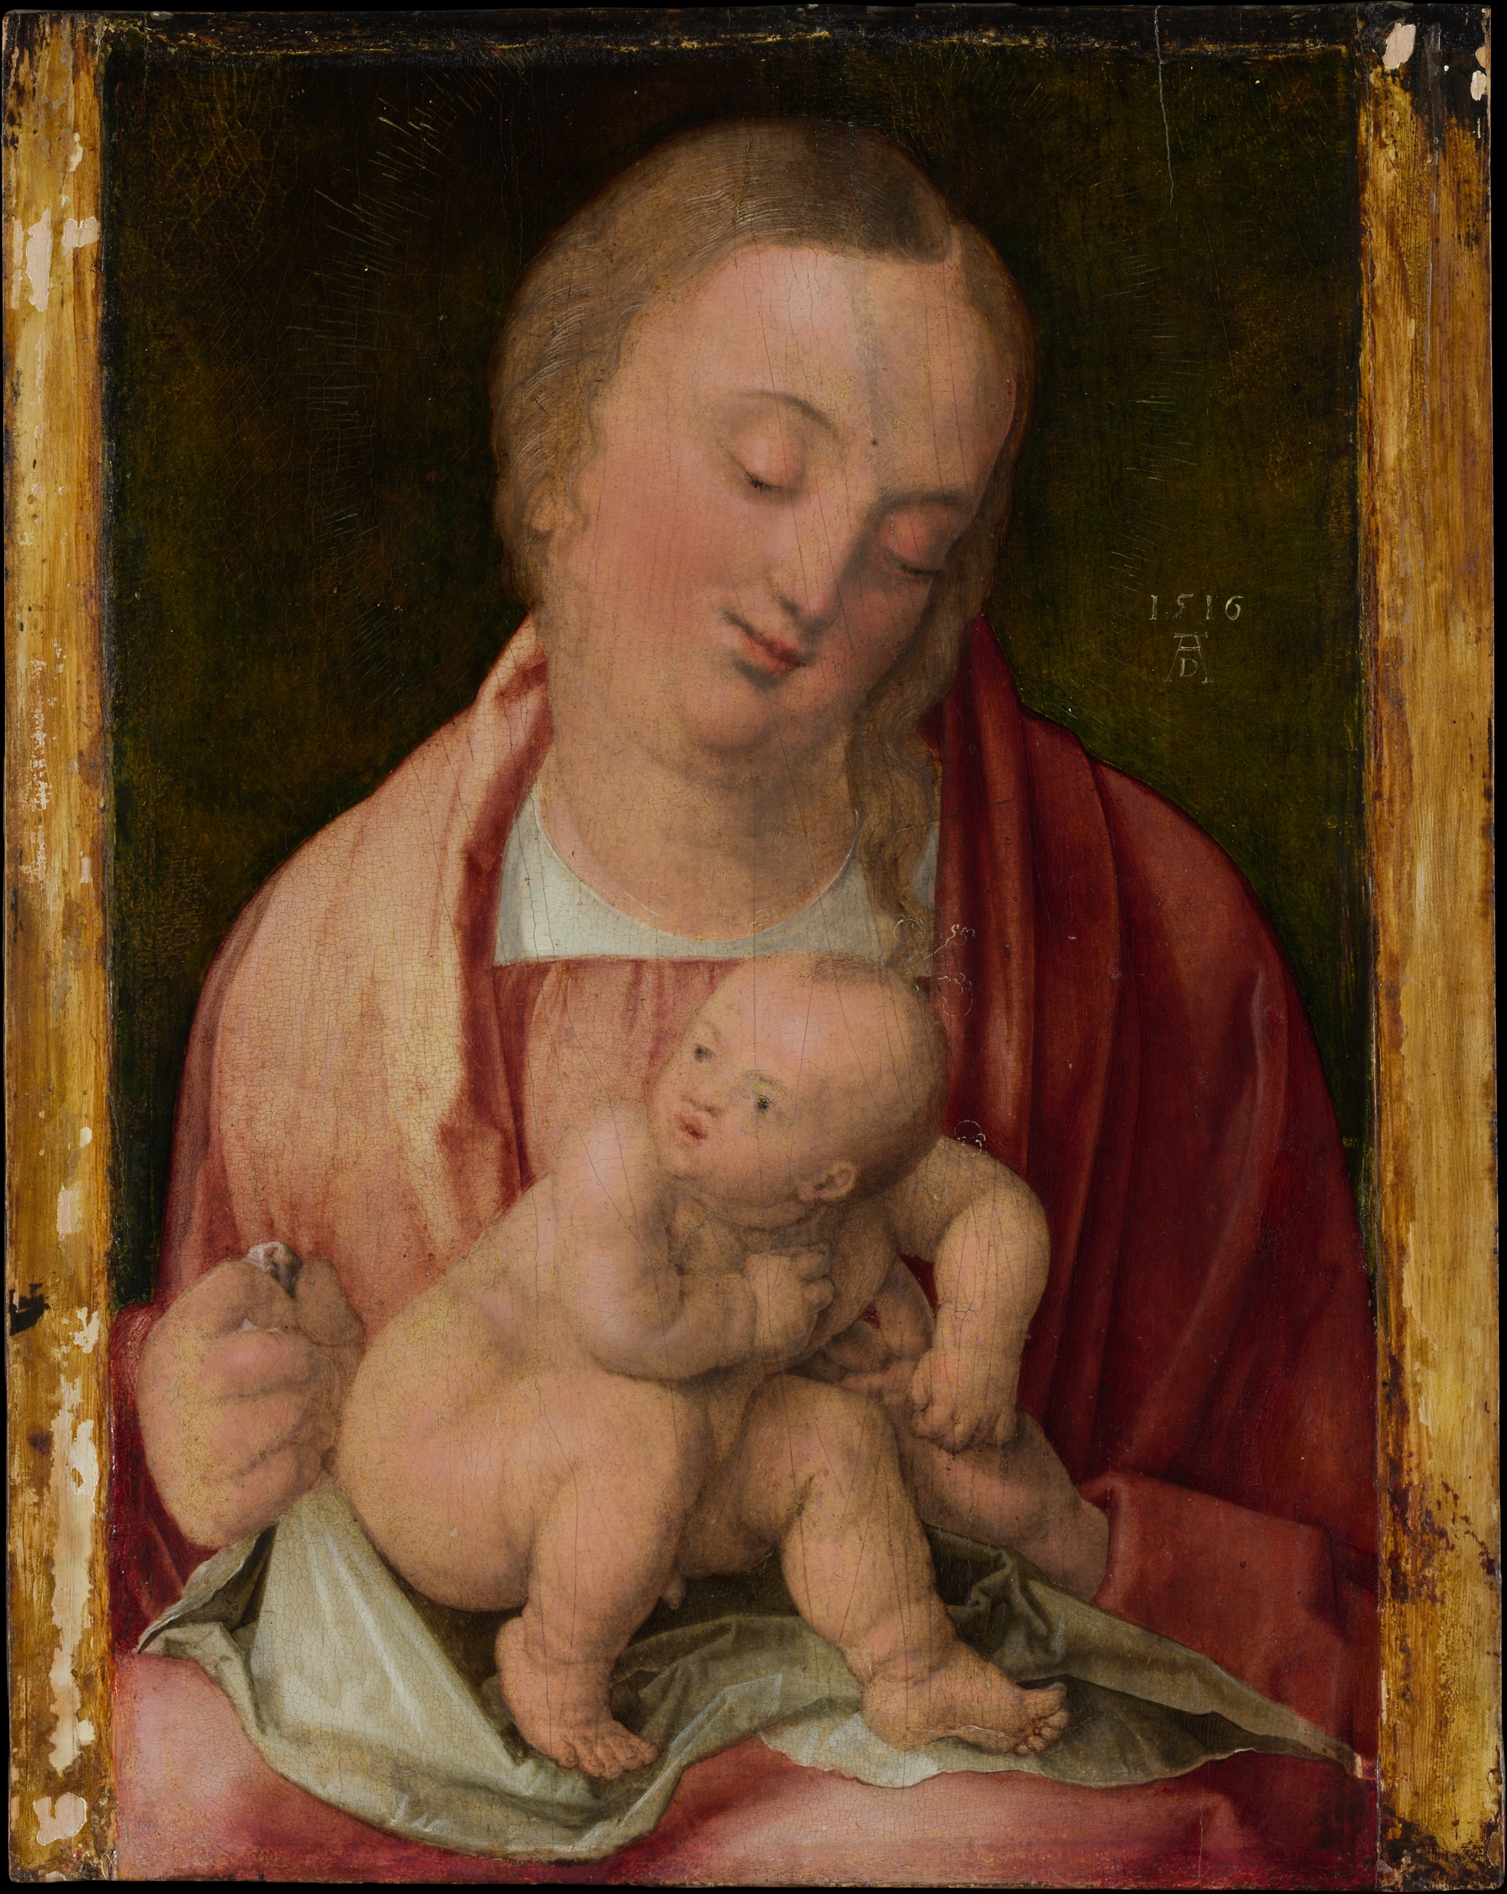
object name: painting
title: Virgin and Child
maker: albrecht dürer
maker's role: artist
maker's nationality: german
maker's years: 1471-1528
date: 1516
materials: oil, wood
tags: madonna and child